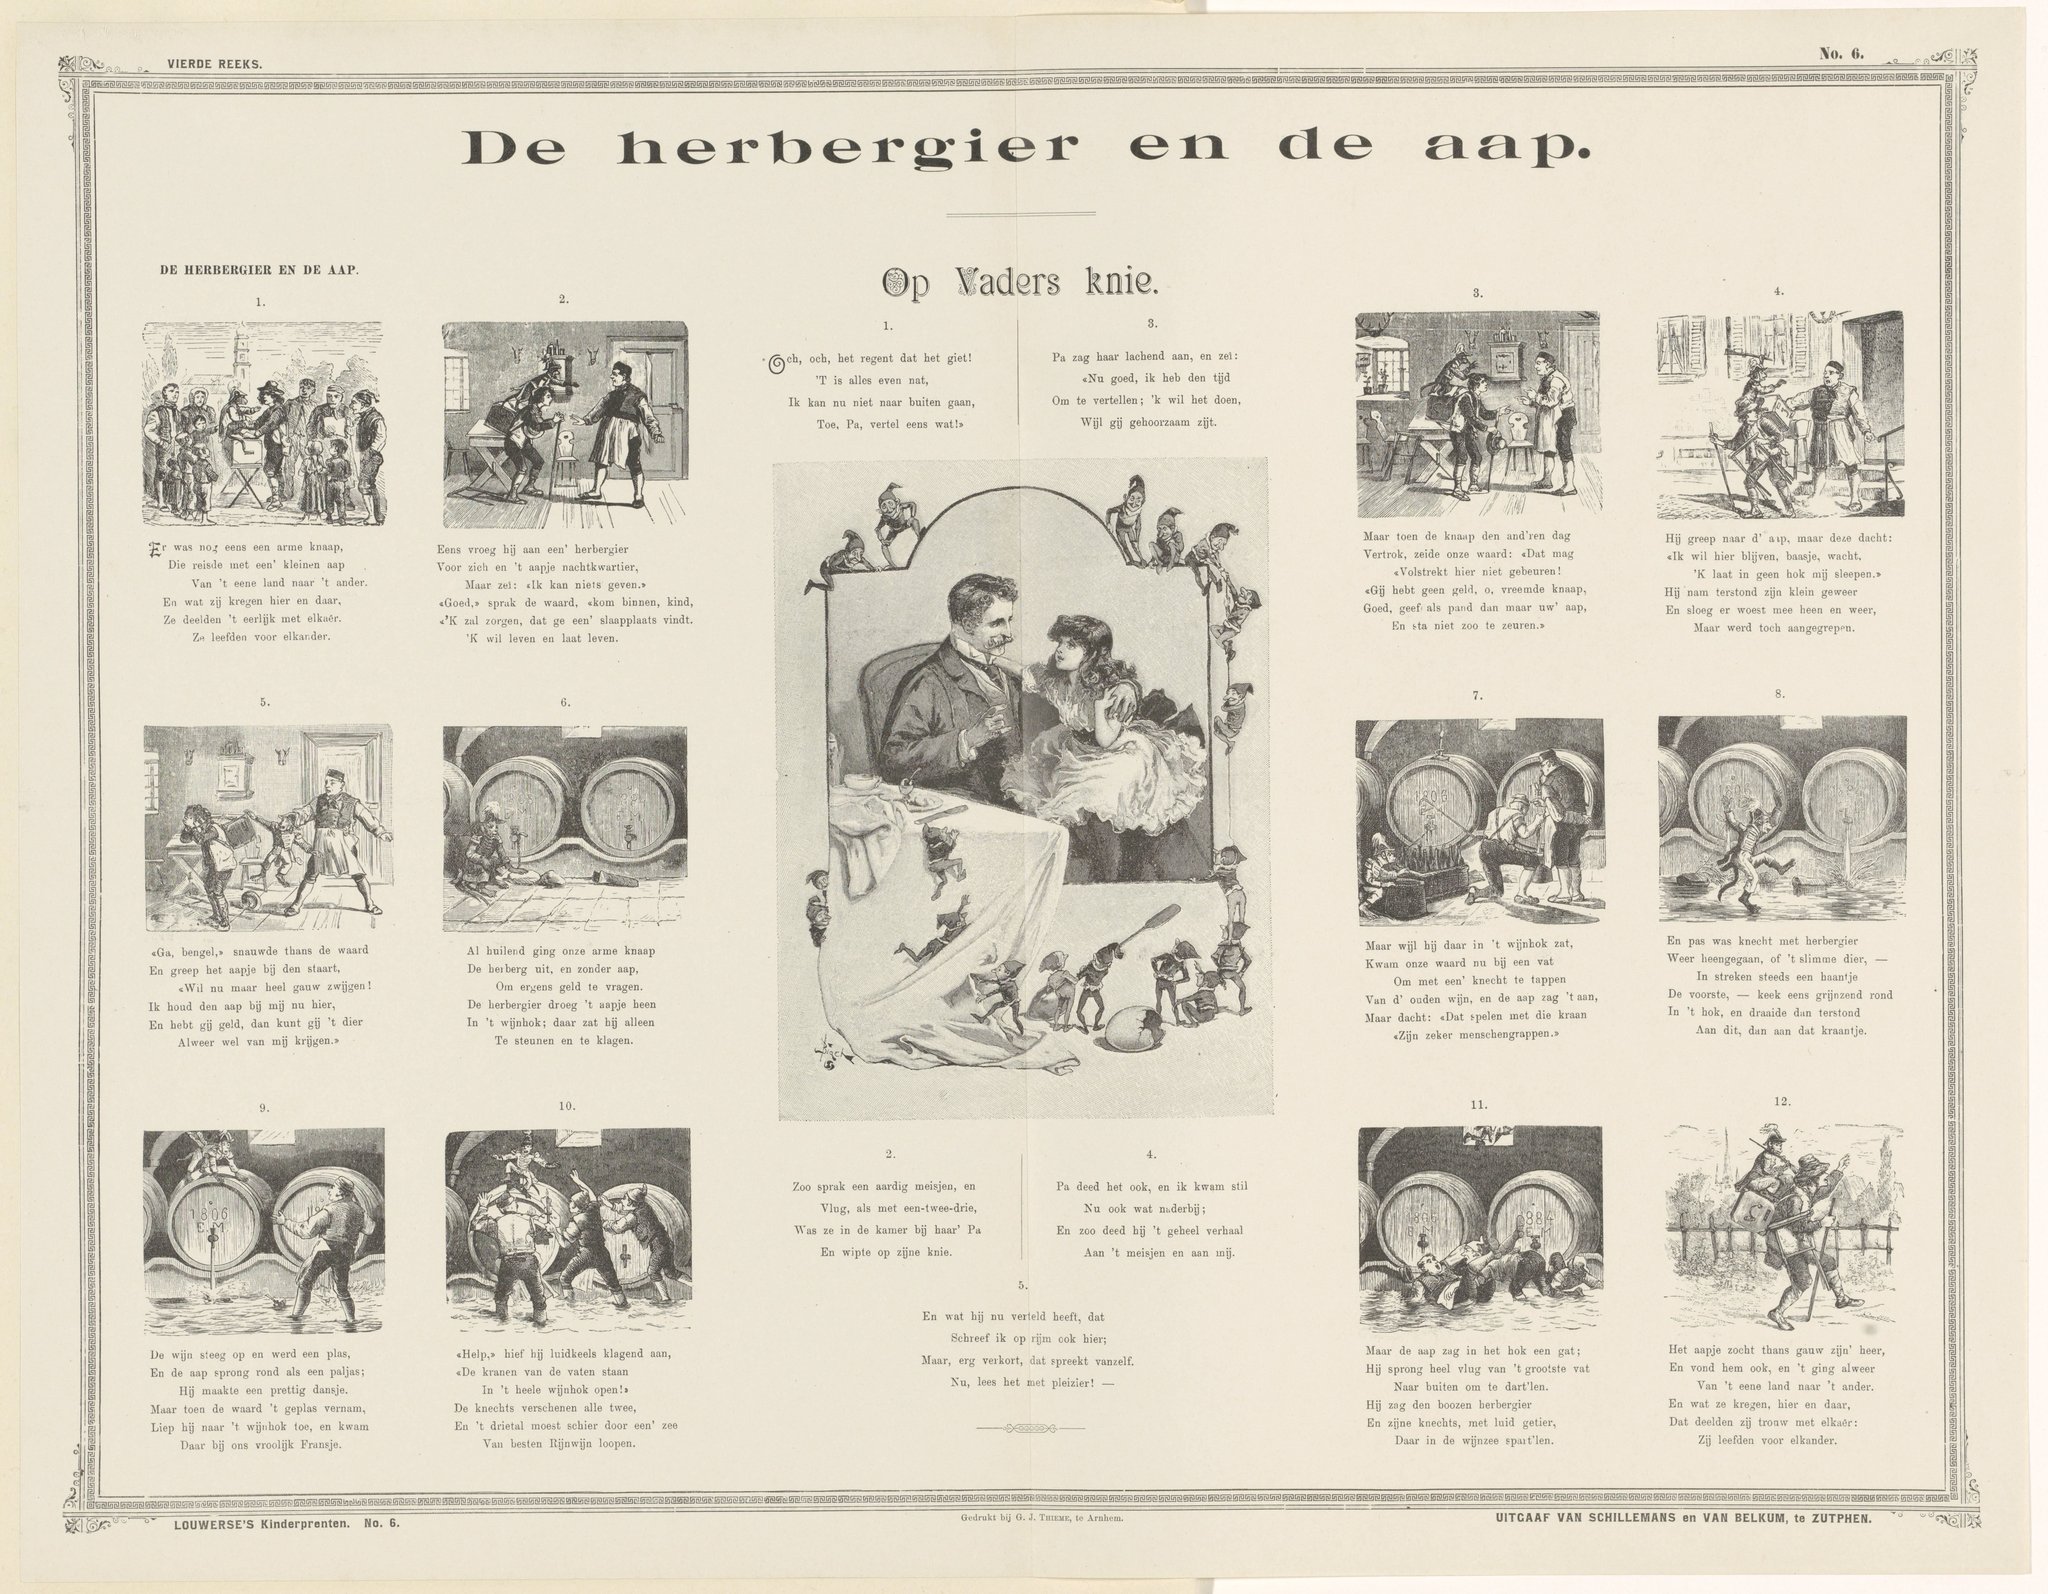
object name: print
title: Vierde reeks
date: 1905-1924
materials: paper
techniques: letterpress printing, printing block, engraving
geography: arnhem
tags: father and daughter(s) (family group), wine-cellar, monkeys, apes, hotel, hostelry, inn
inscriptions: collector's mark: Lugt 2760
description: Blad met 13 voorstellingen. Links en rechts twaalf kleine genummerde voorstellingen die samen het verhaal vertellen van een herbergier en een aap. In het midden een grote voorstelling van een meisje bij haar vader op schoot. Tussen de afbeeldingen versjes in boekdruk. Genummerd rechtsboven en linksonder: No. 6.